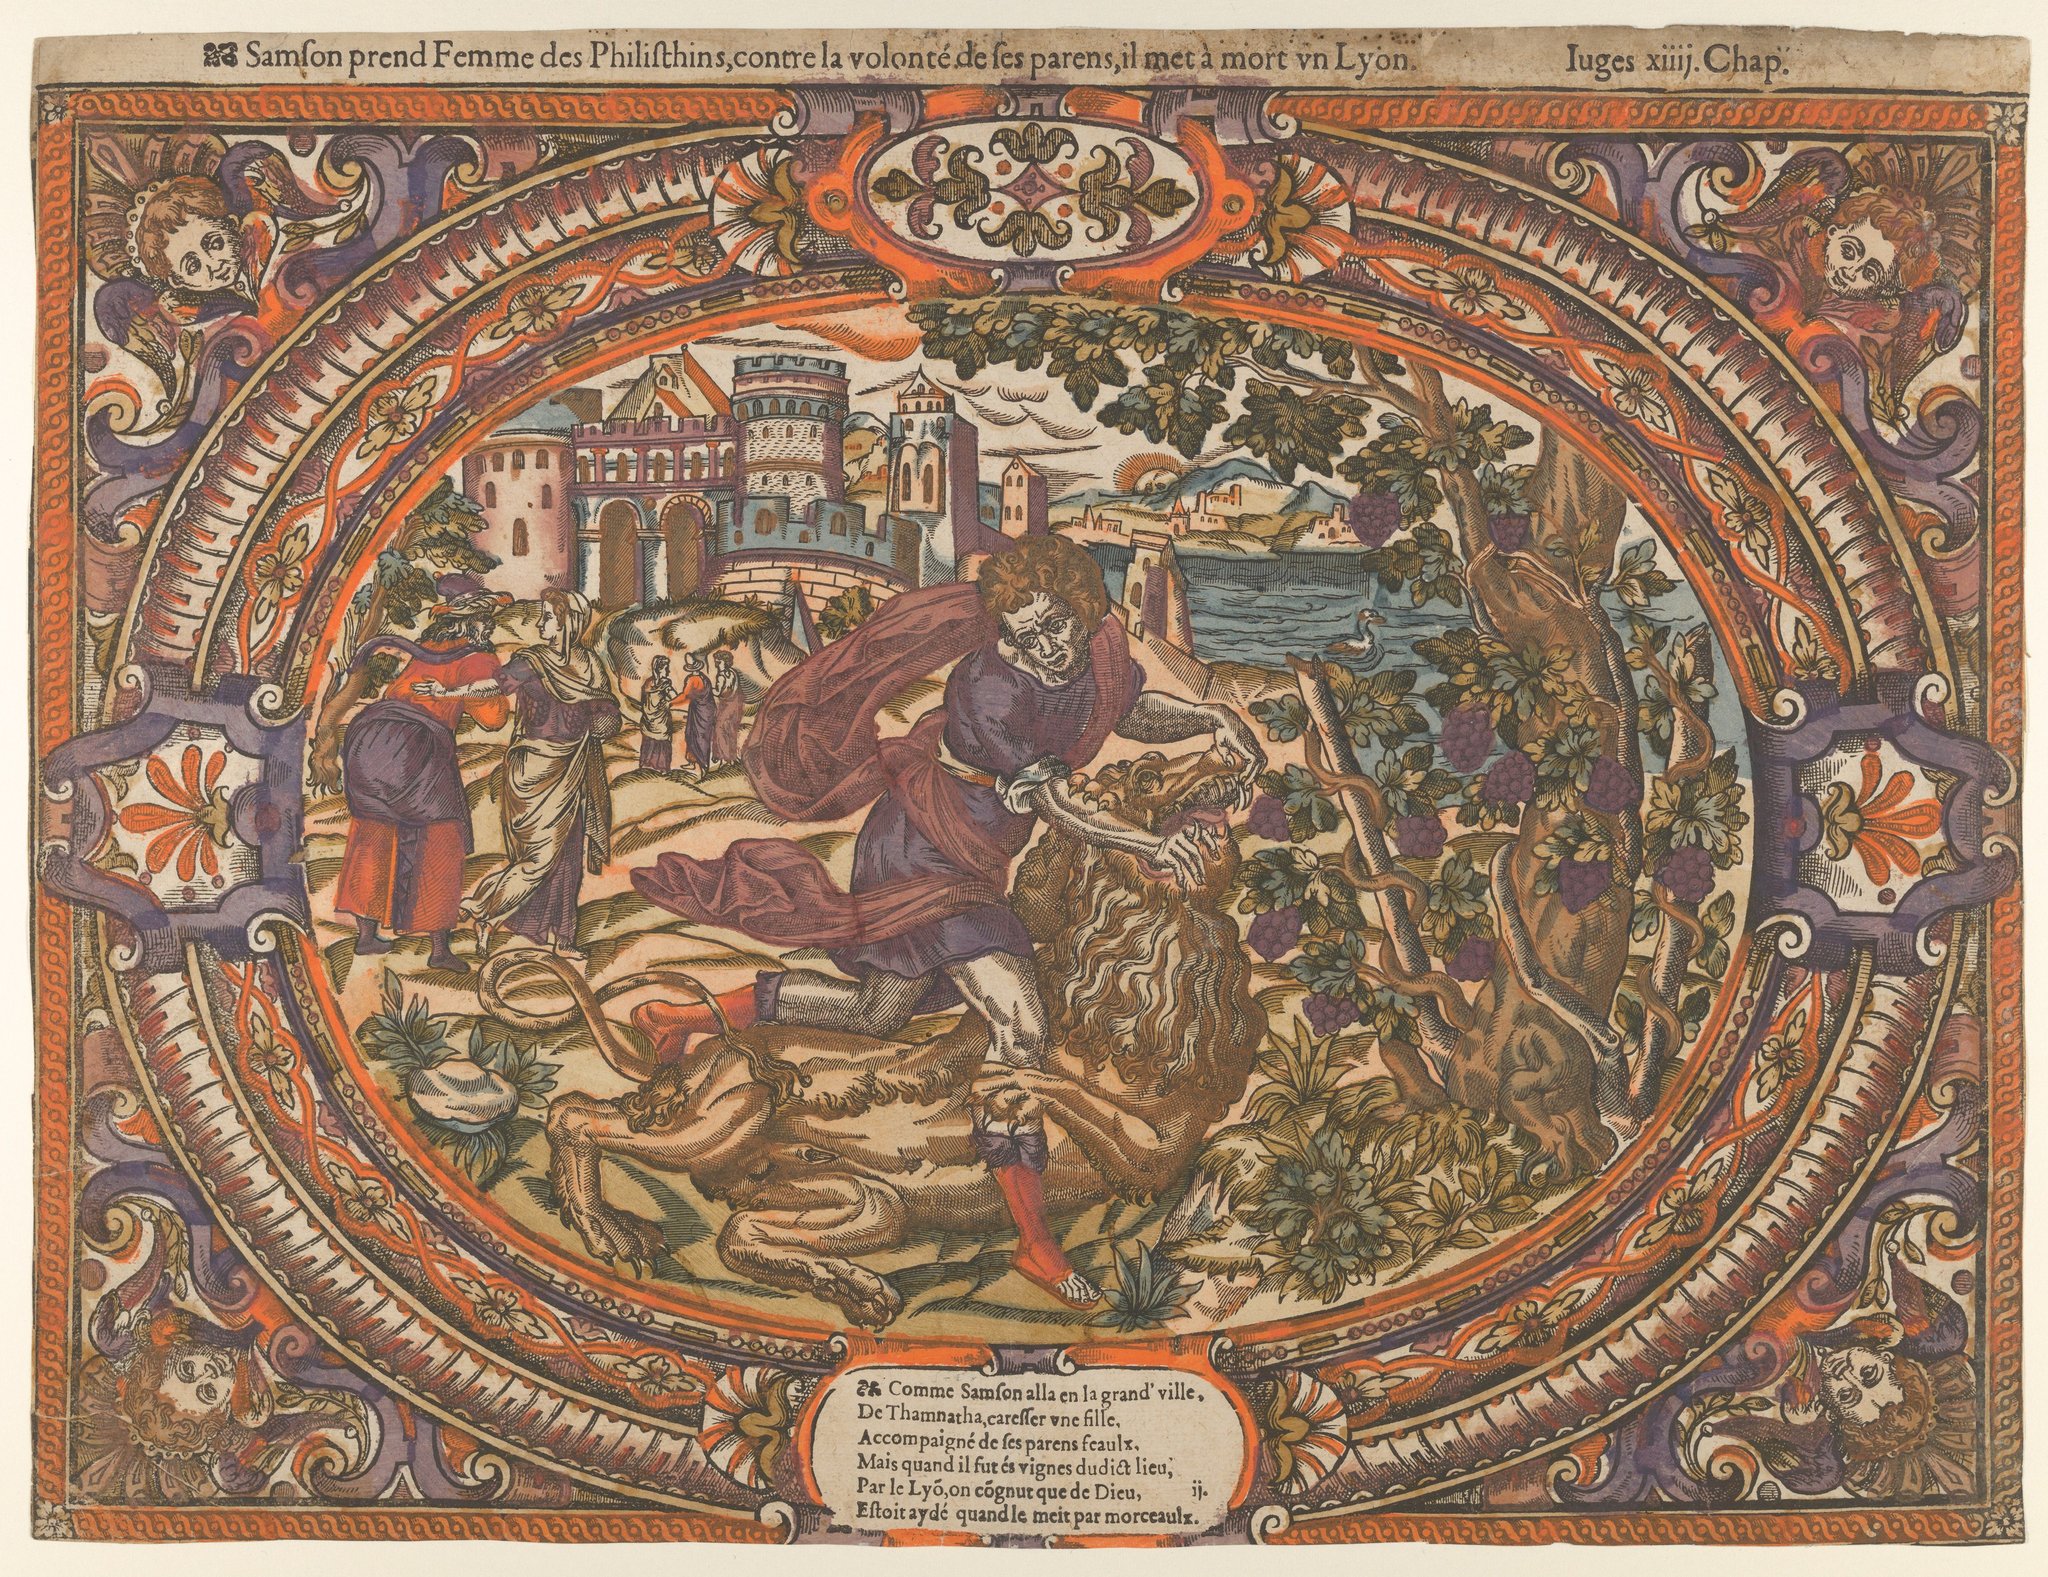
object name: print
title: Samson and the Lion, from "The Story of Samson"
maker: anonymous, french, 16th century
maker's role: artist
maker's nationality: french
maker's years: 1500-1600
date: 1560-1580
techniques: hand coloring, pochoir, woodcut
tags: lions,samson